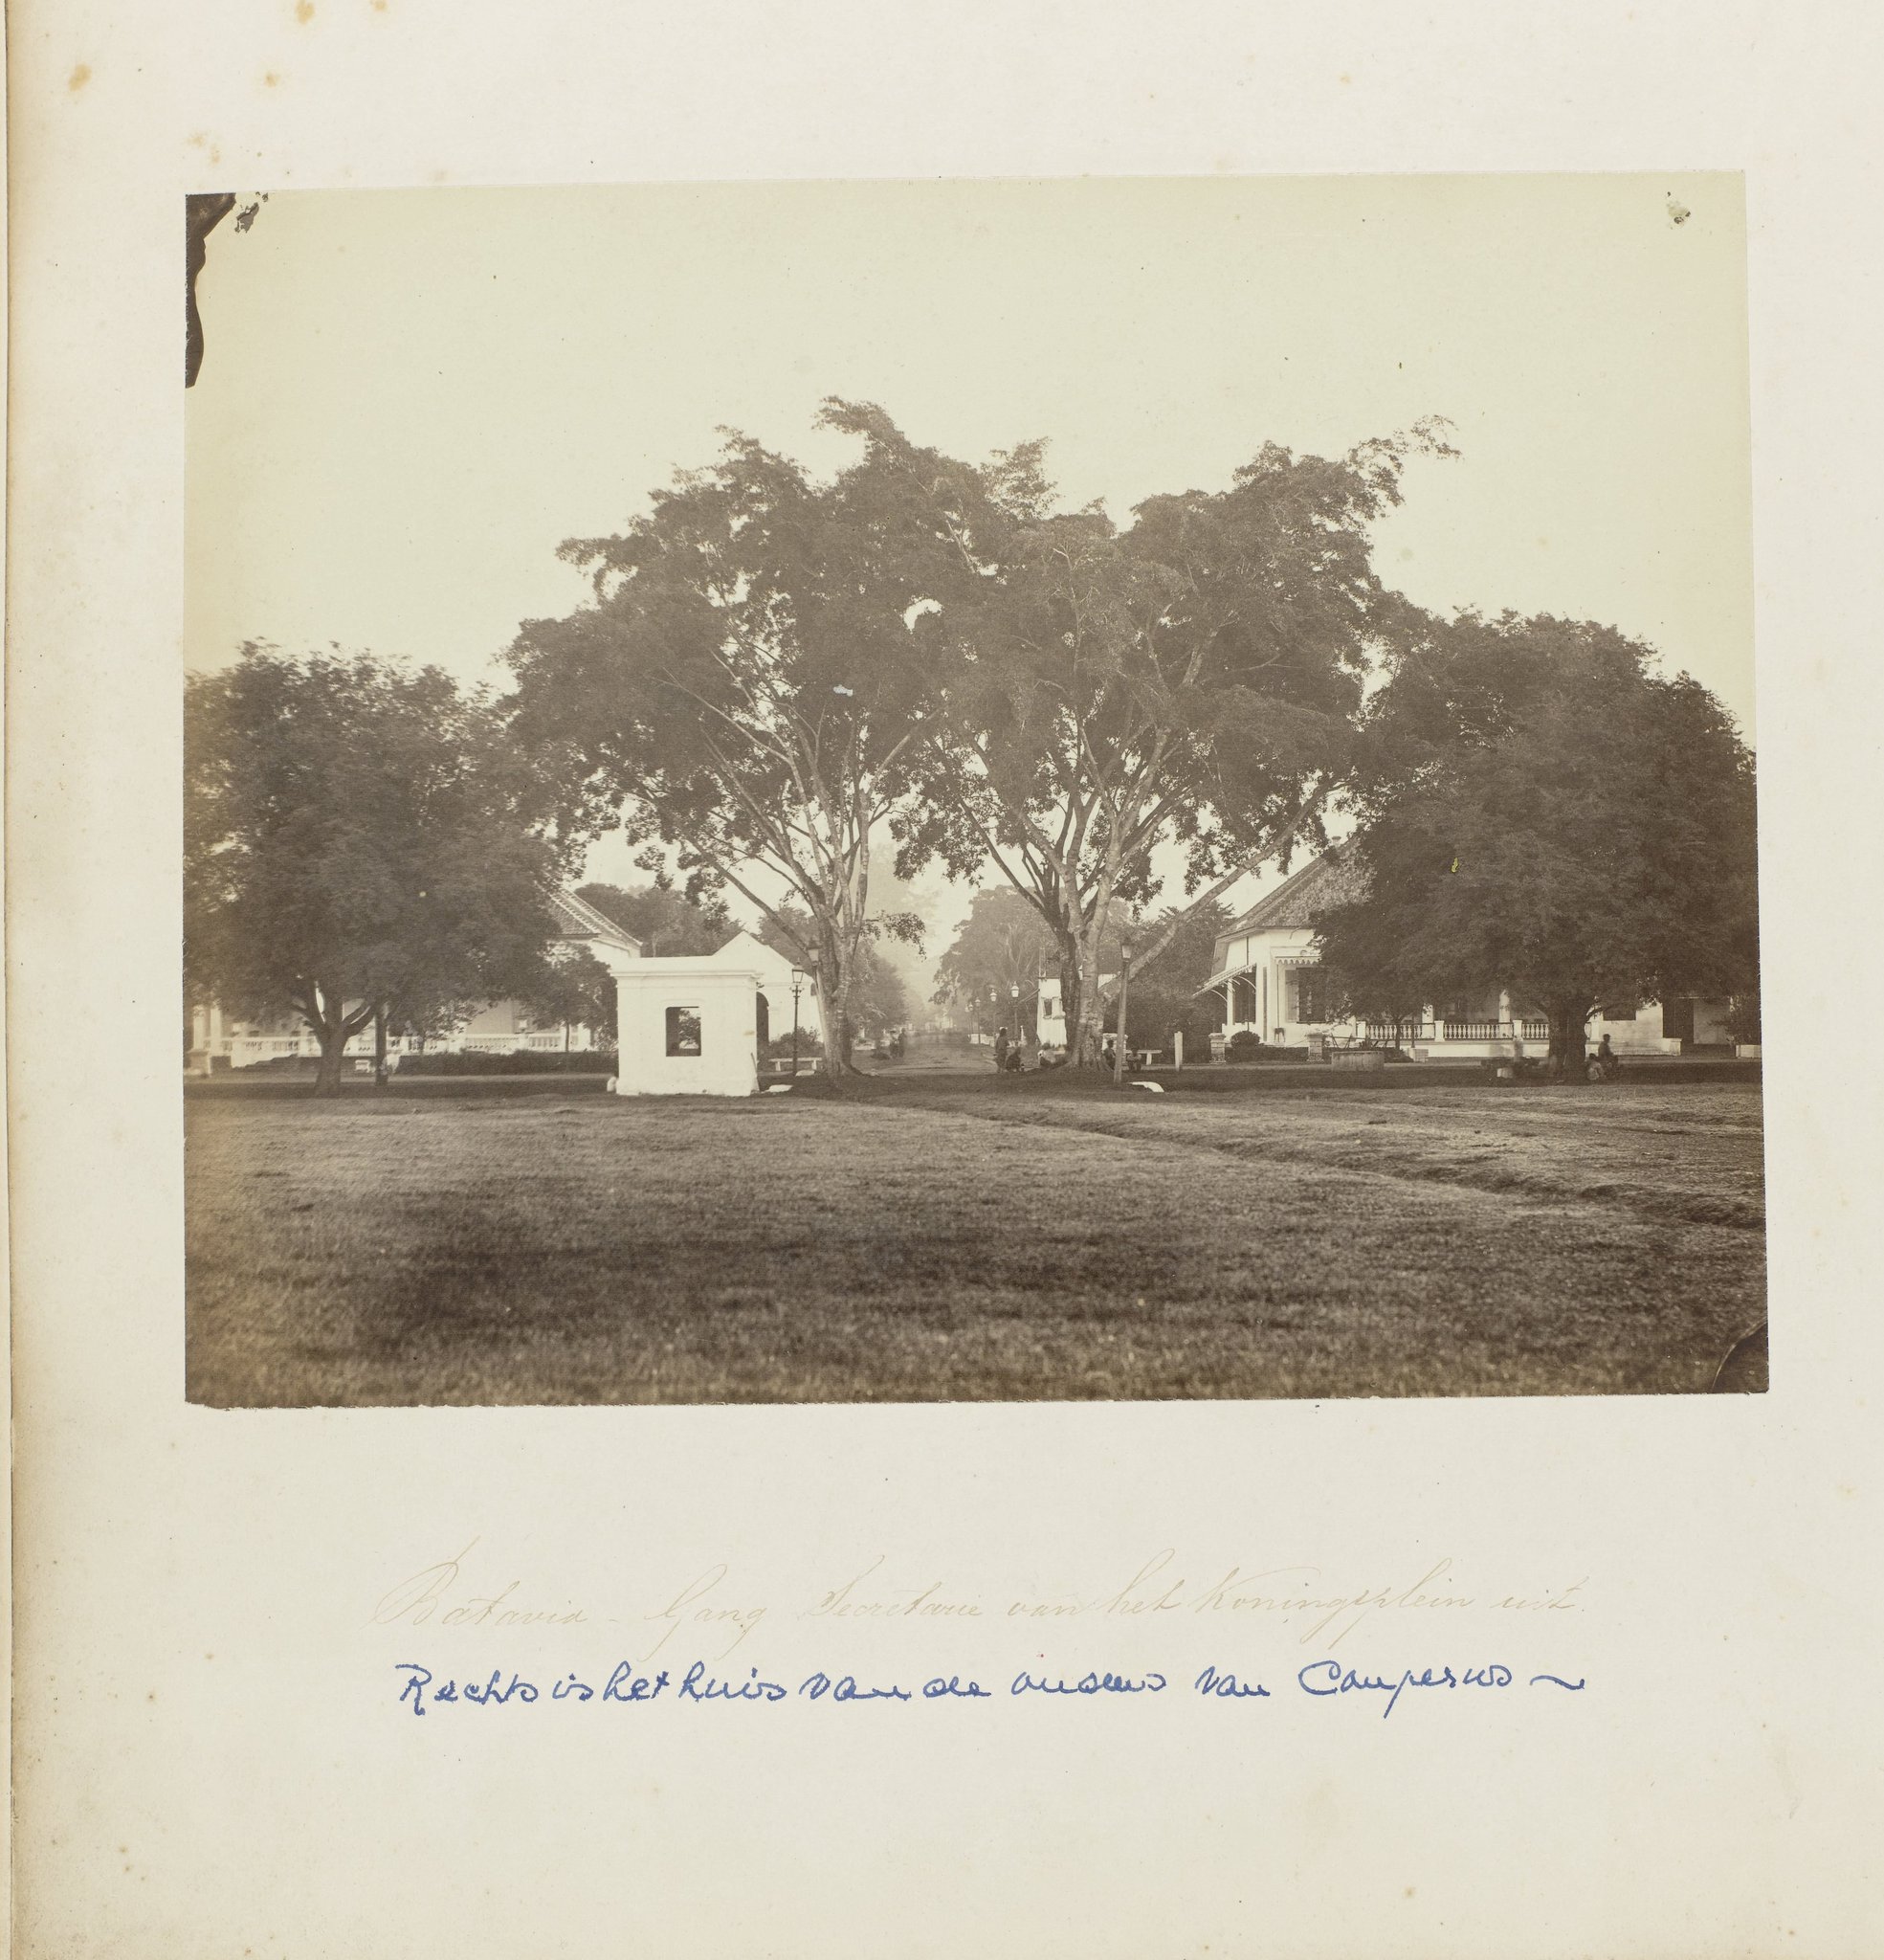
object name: photograph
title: Batavia - Gang Secretarie van het Koningsplein uit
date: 1863-1866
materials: photographic support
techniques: albumen print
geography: batavia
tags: louis couperus, detached house in city, batavia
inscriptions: inscription: ‘Batavia - Gang Secretaire van het Koningsplein uit’, inscription: ‘Rechts is het huis van de ouders van Couperus.’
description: Gezicht in de Gang Secretarie vanuit het Koningsplein te Batavia. Rechts het huis van de ouders van Louis Couperus. Onderdeel van het rode fotoalbum met foto's van Java, uit het bezit van apotheker Specht-Grijp, die in 1865 vanuit Batavia naar Nederland terugkeerde.